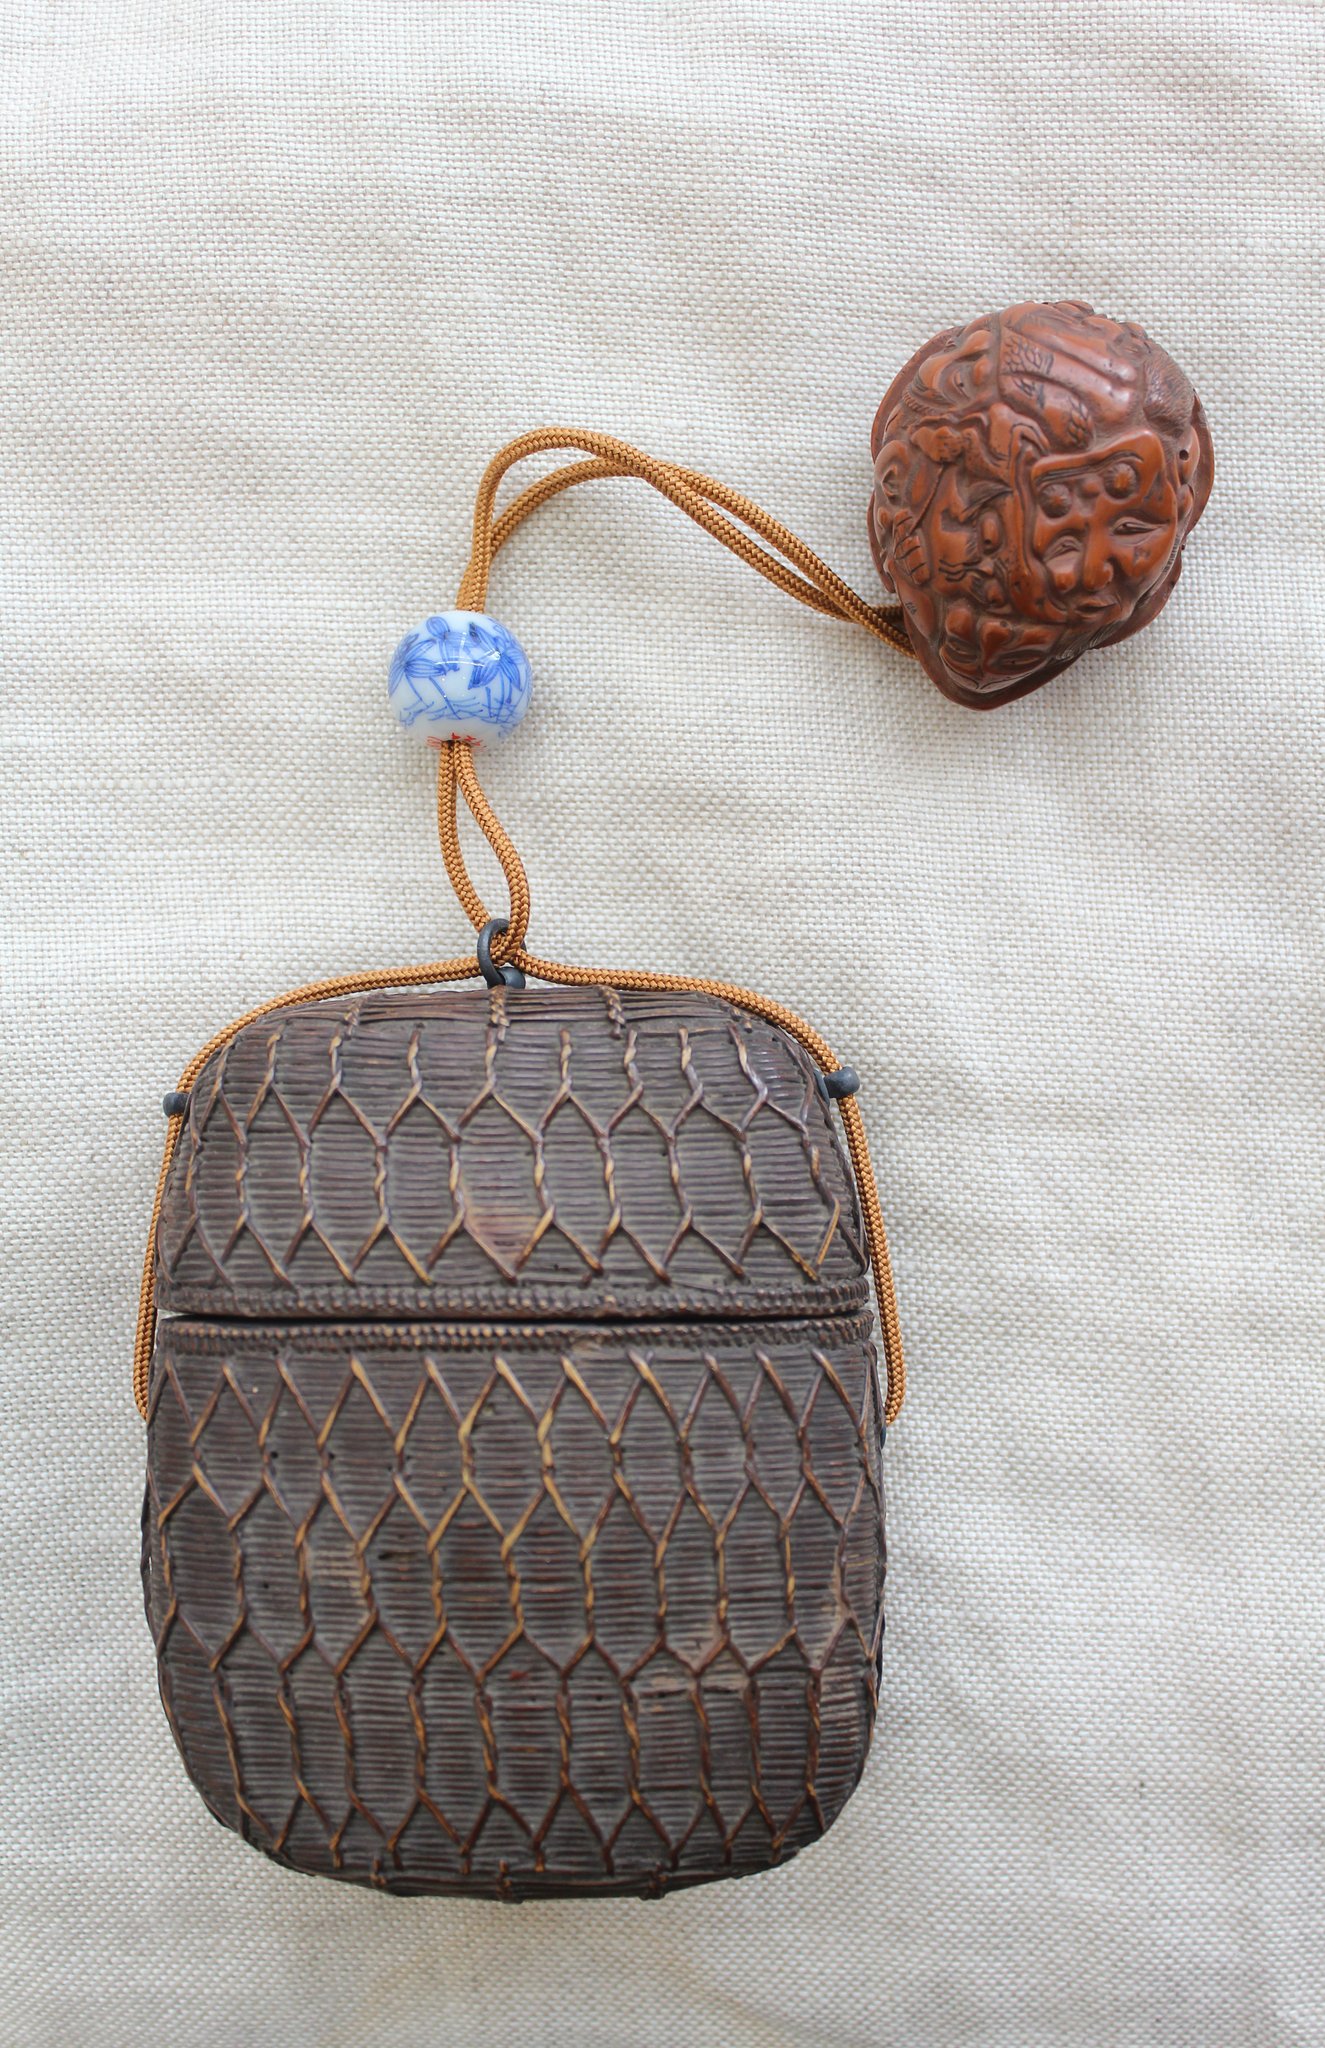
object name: inrō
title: Basketry Inrō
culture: japanese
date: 1601-1700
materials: bamboo, lacquer, rattan, wood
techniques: urushi